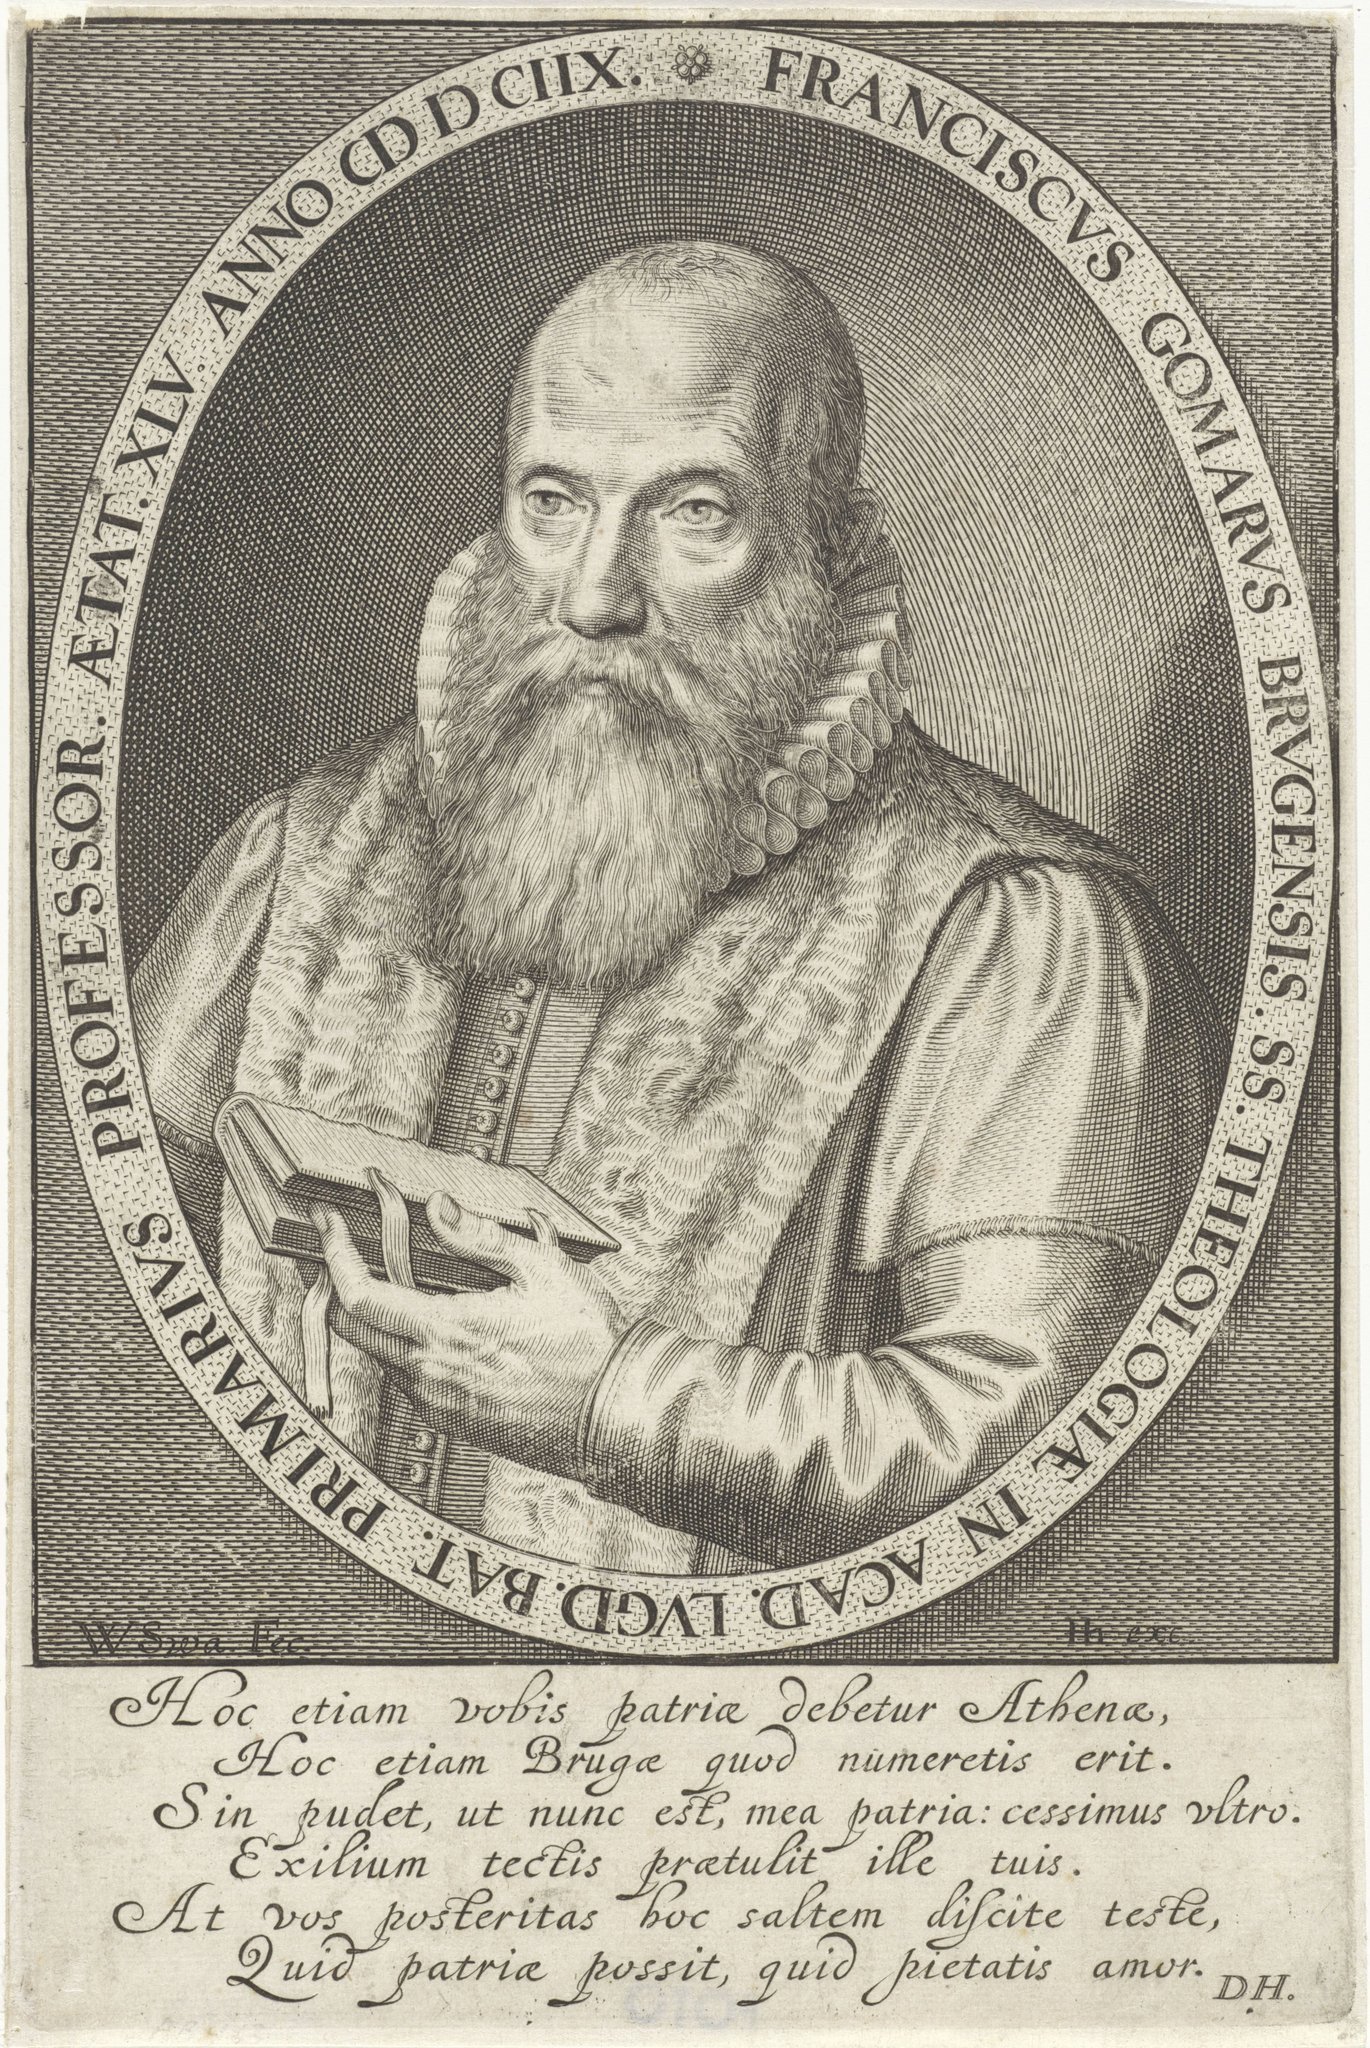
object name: print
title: Portret van Franciscus Gomarus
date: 1608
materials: paper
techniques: engraving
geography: the hague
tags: bruges, theologian, professor (+ portrait of teacher, professor)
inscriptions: collector's mark: Lugt 2228, stamp: ‘FOTO’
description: Portret van Franciscus Gomarus, hoogleraar theologie aan de universiteit van Leiden, met een boek in de hand, op 45-jarige leeftijd. Onderaan in de marge een zesregelig vers in het Latijn.